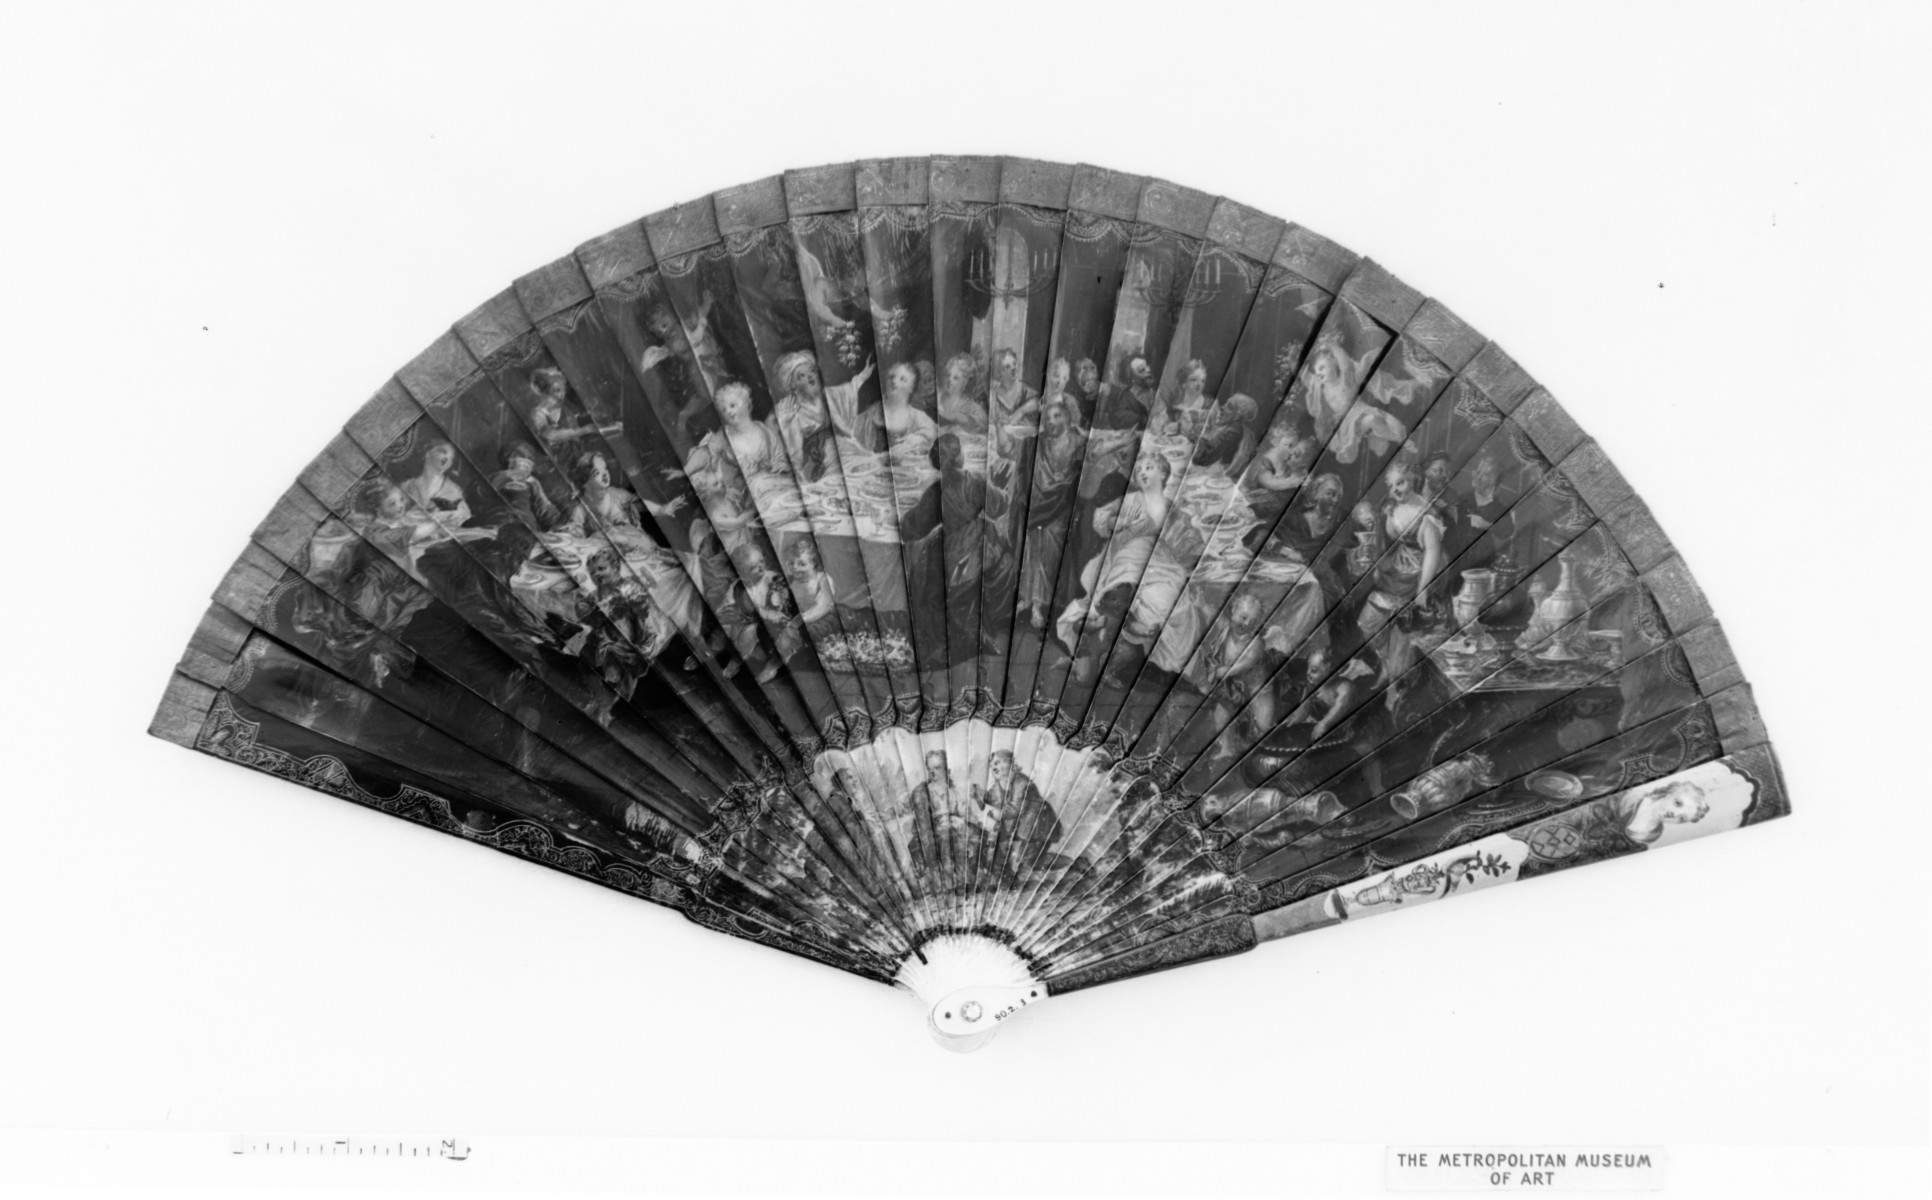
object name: fan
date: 1701-1733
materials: ivory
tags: men,women,putti,dining